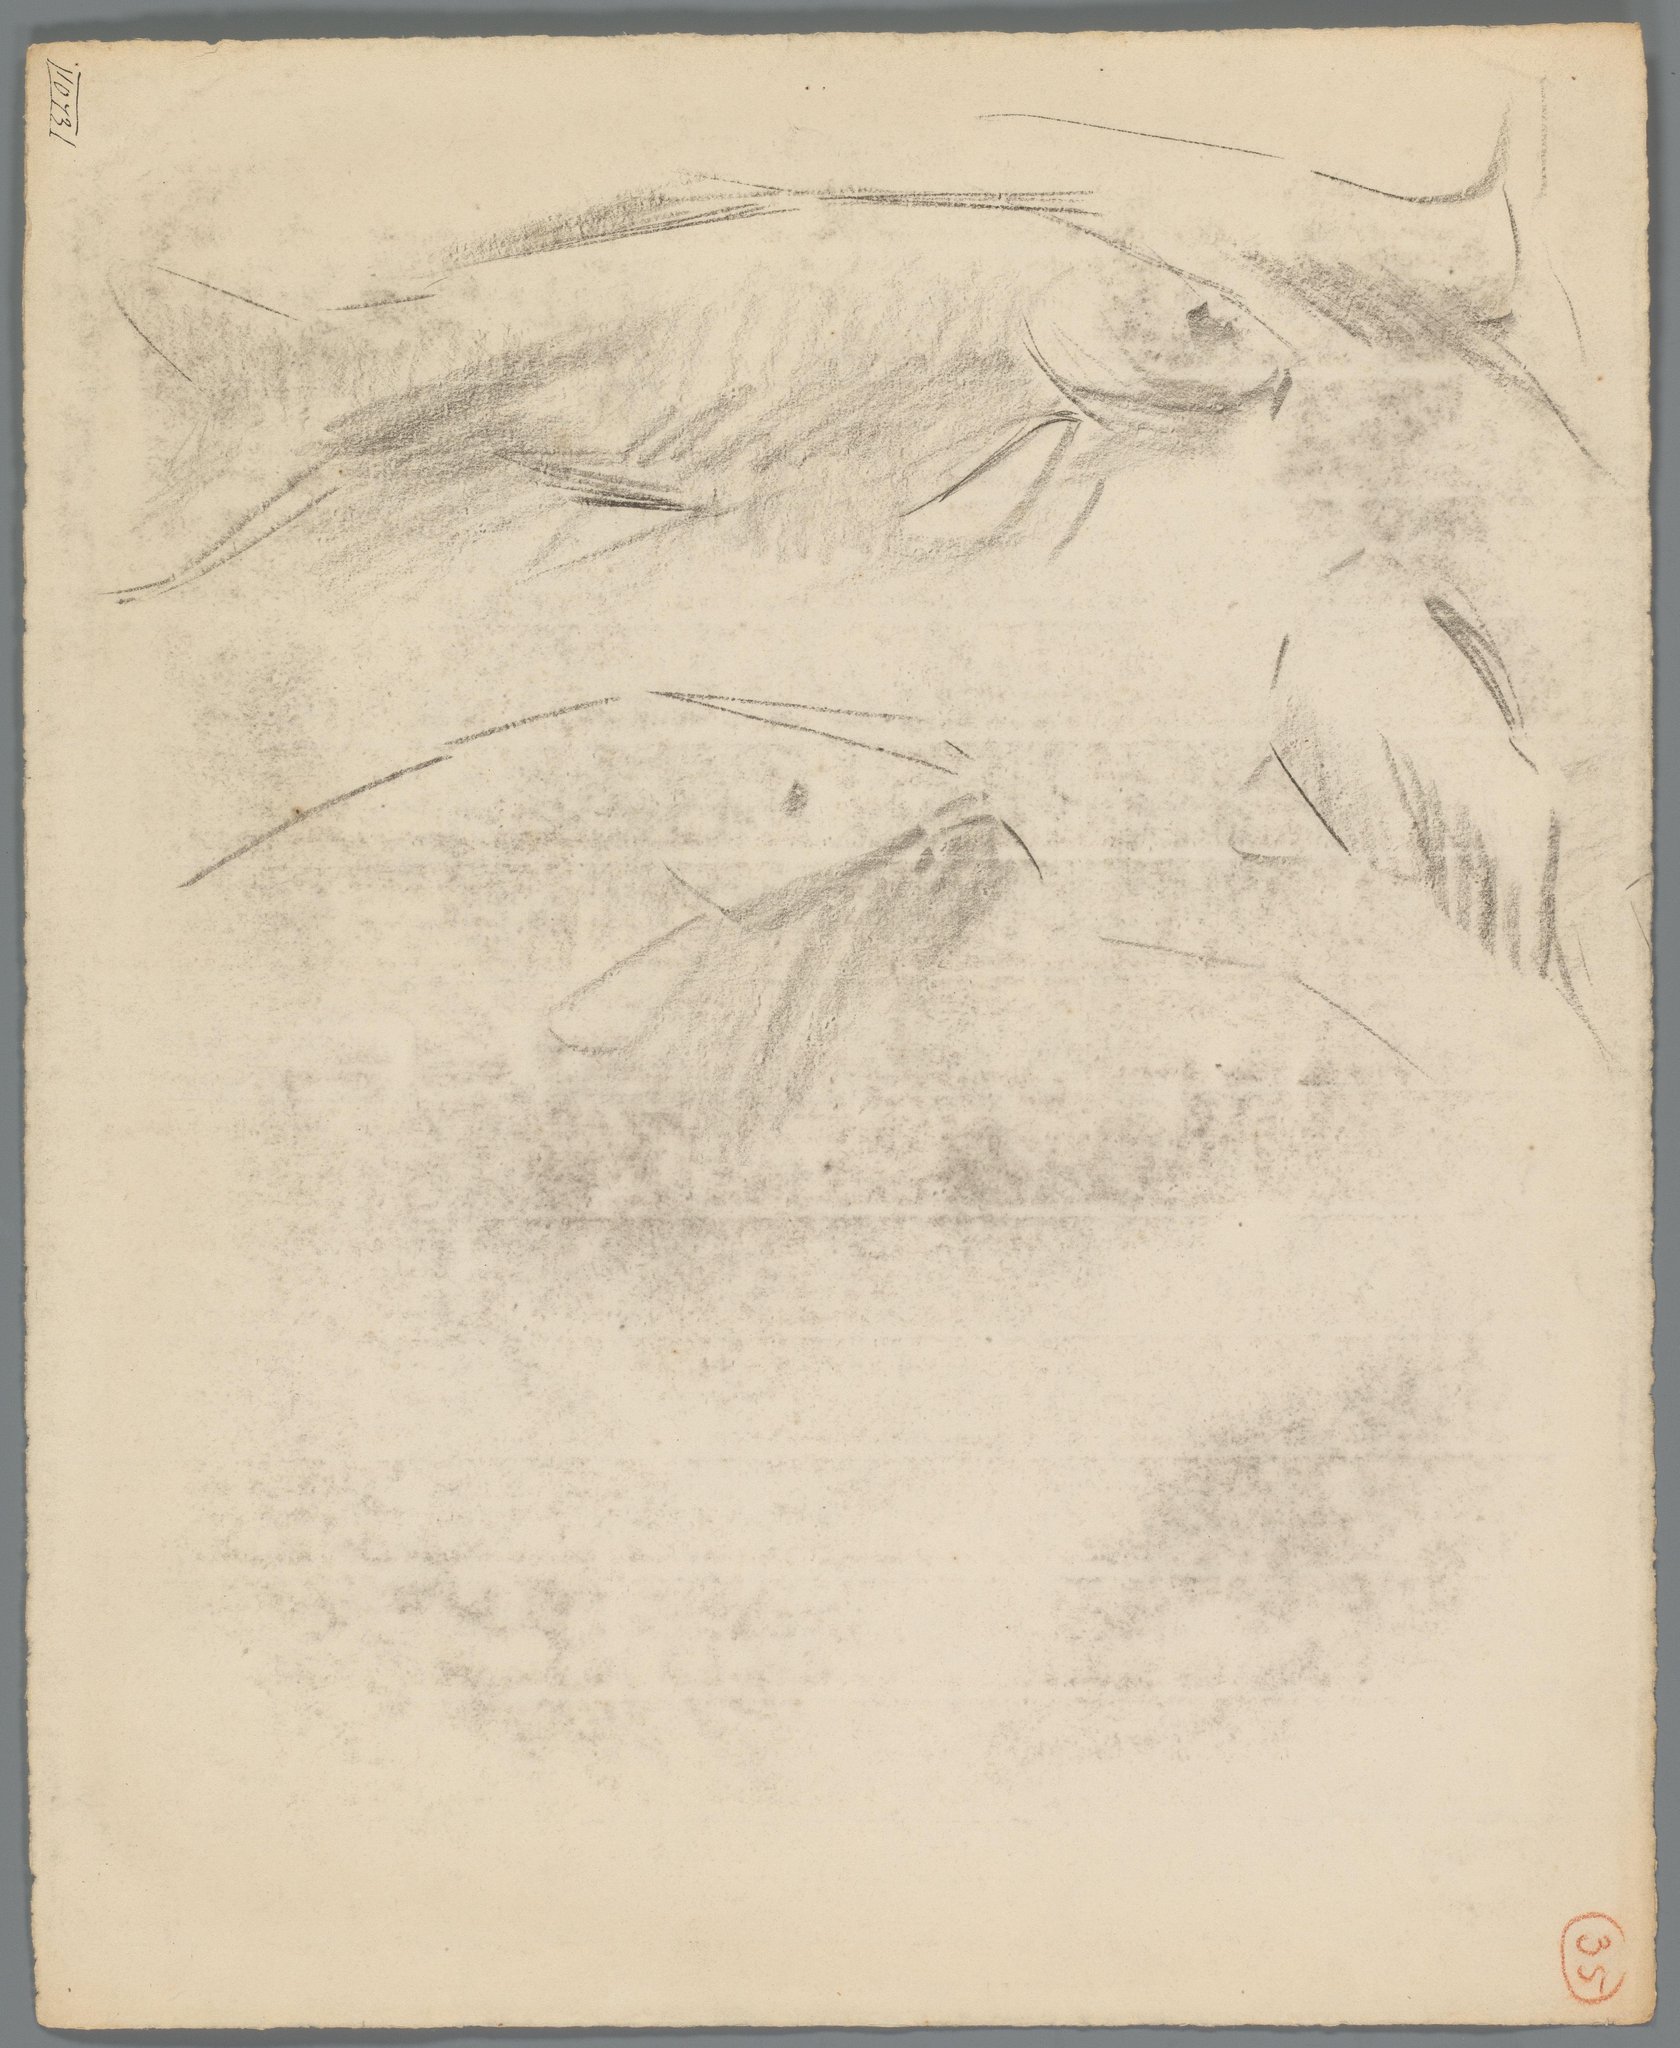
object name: drawing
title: Studies van karpers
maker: gerrit willem dijsselhof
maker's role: designer, draughtsman, print maker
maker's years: 1866-1924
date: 1876-1924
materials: chalk, paper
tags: bony fishes: carp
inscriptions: number: ‘1073’